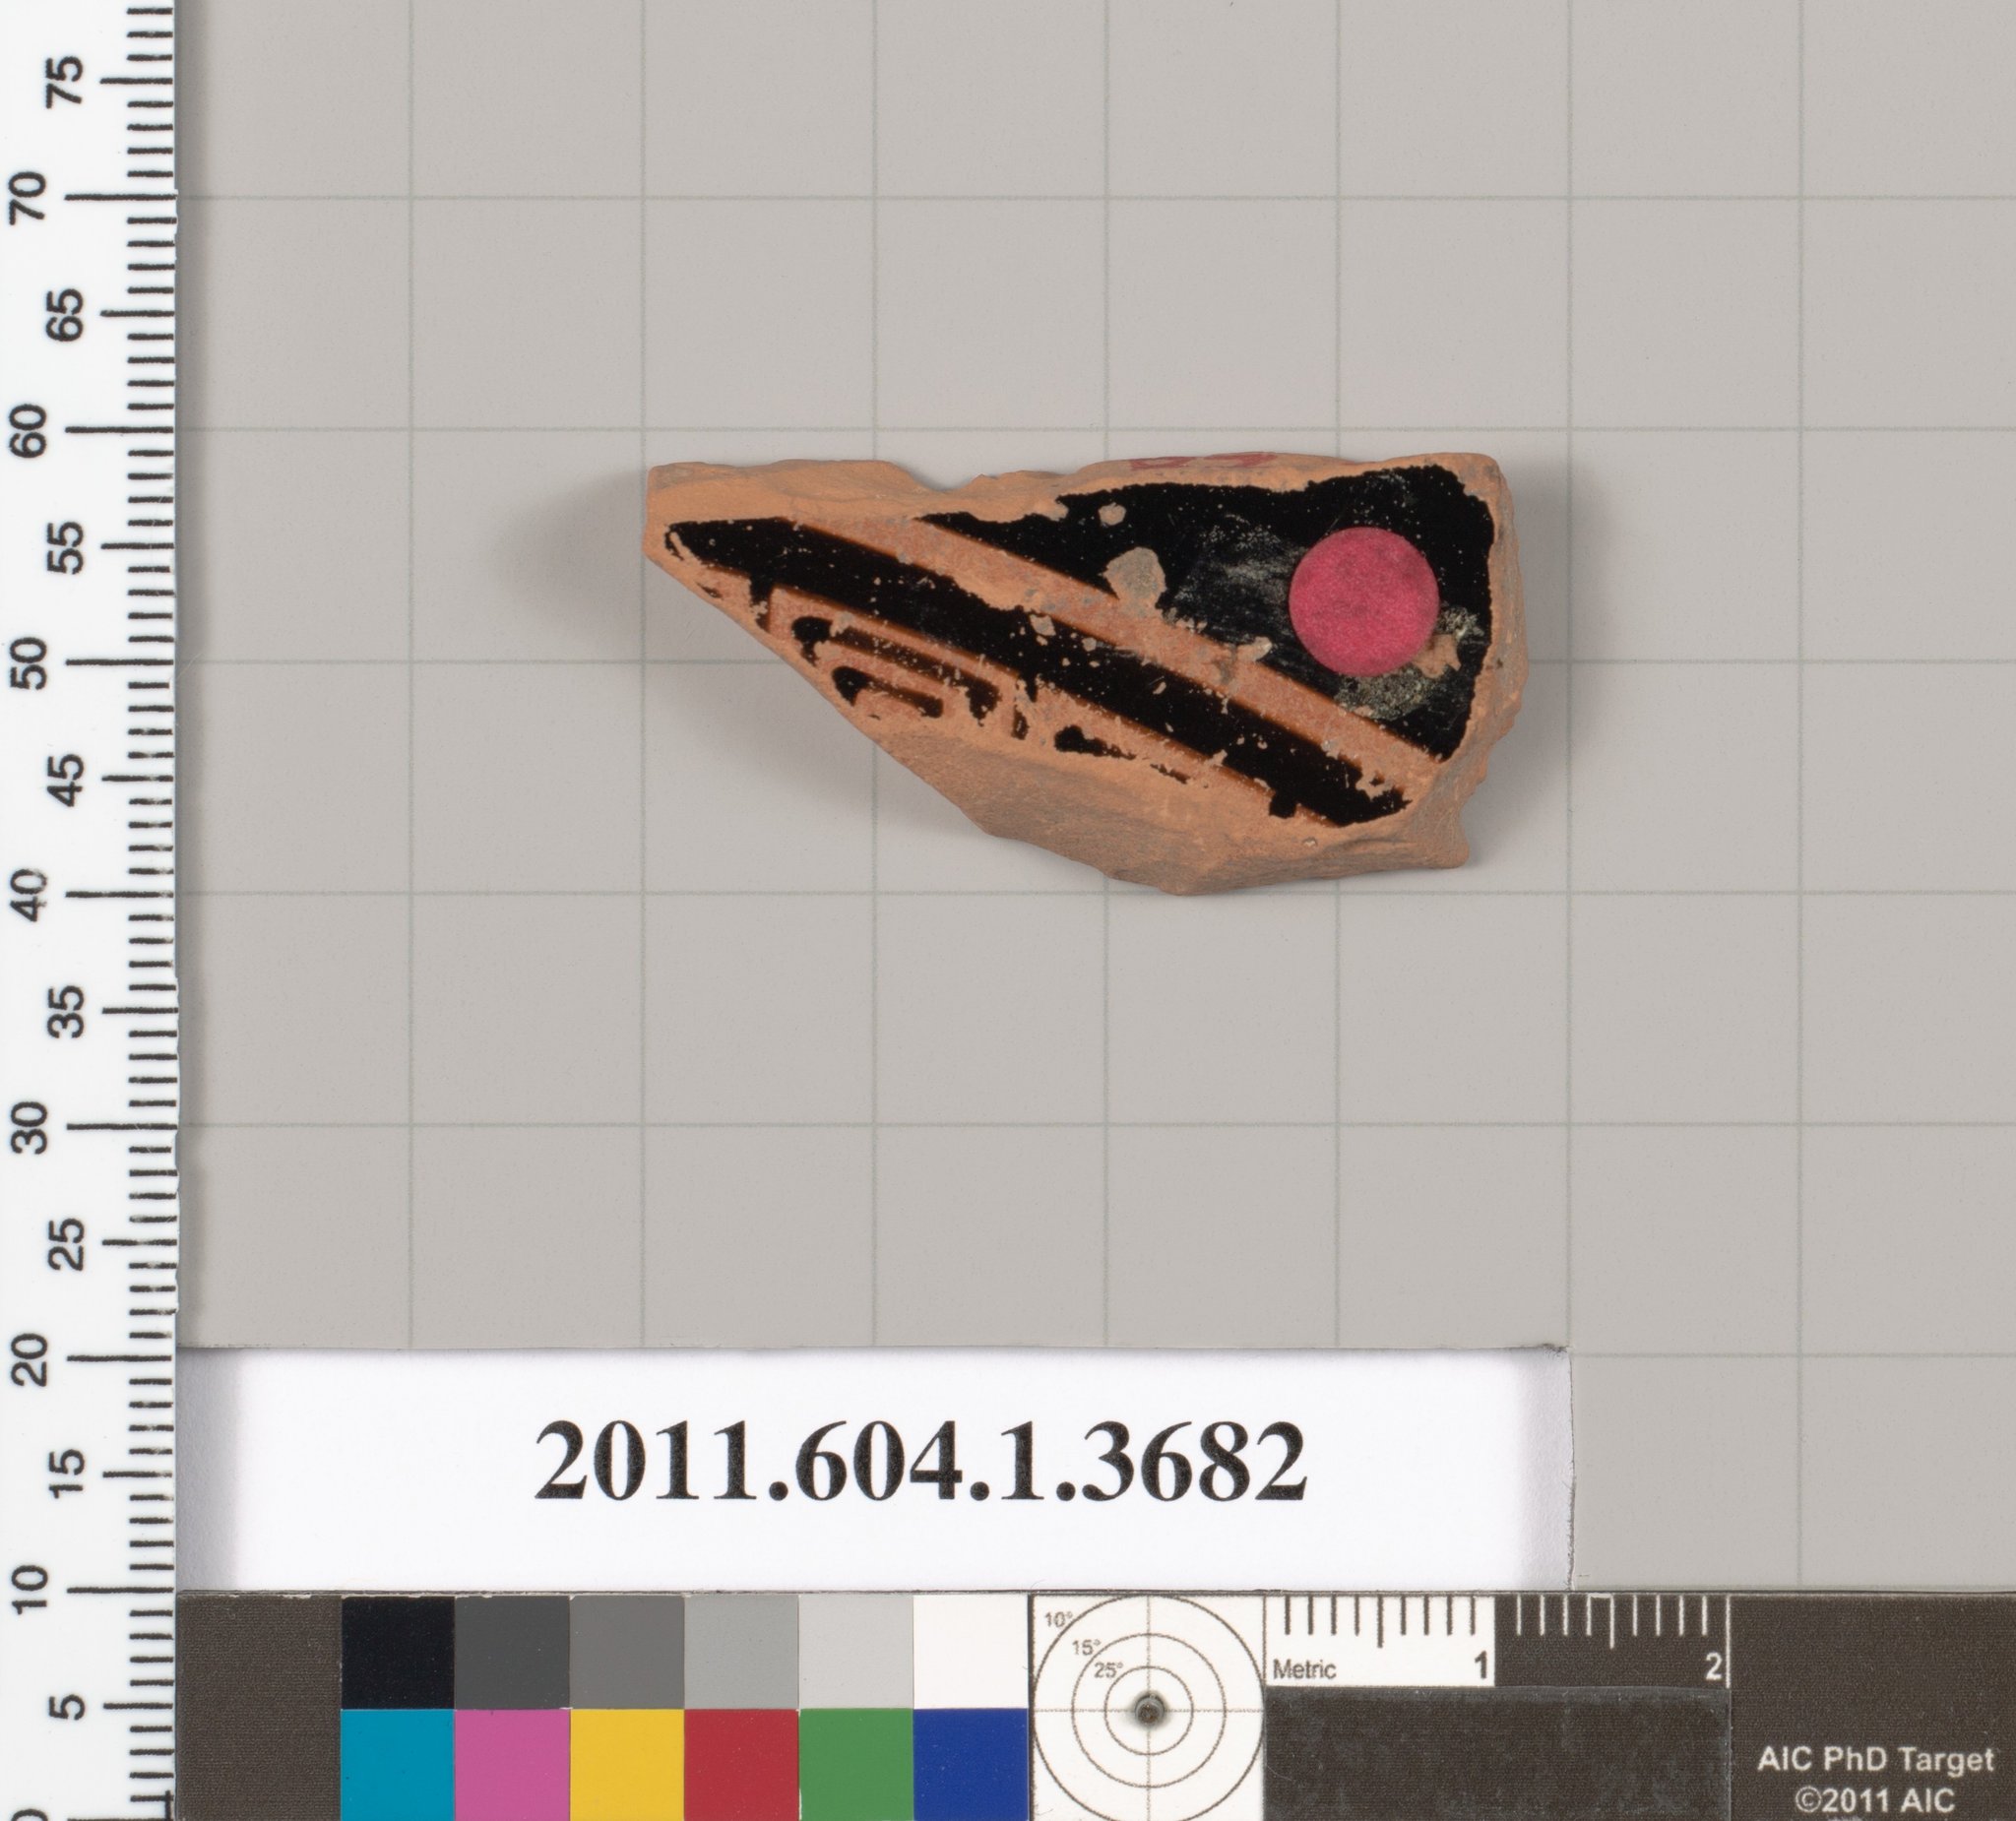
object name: kylix fragment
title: Terracotta fragment of a kylix (drinking cup)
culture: greek, attic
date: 490-470 BCE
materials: terracotta